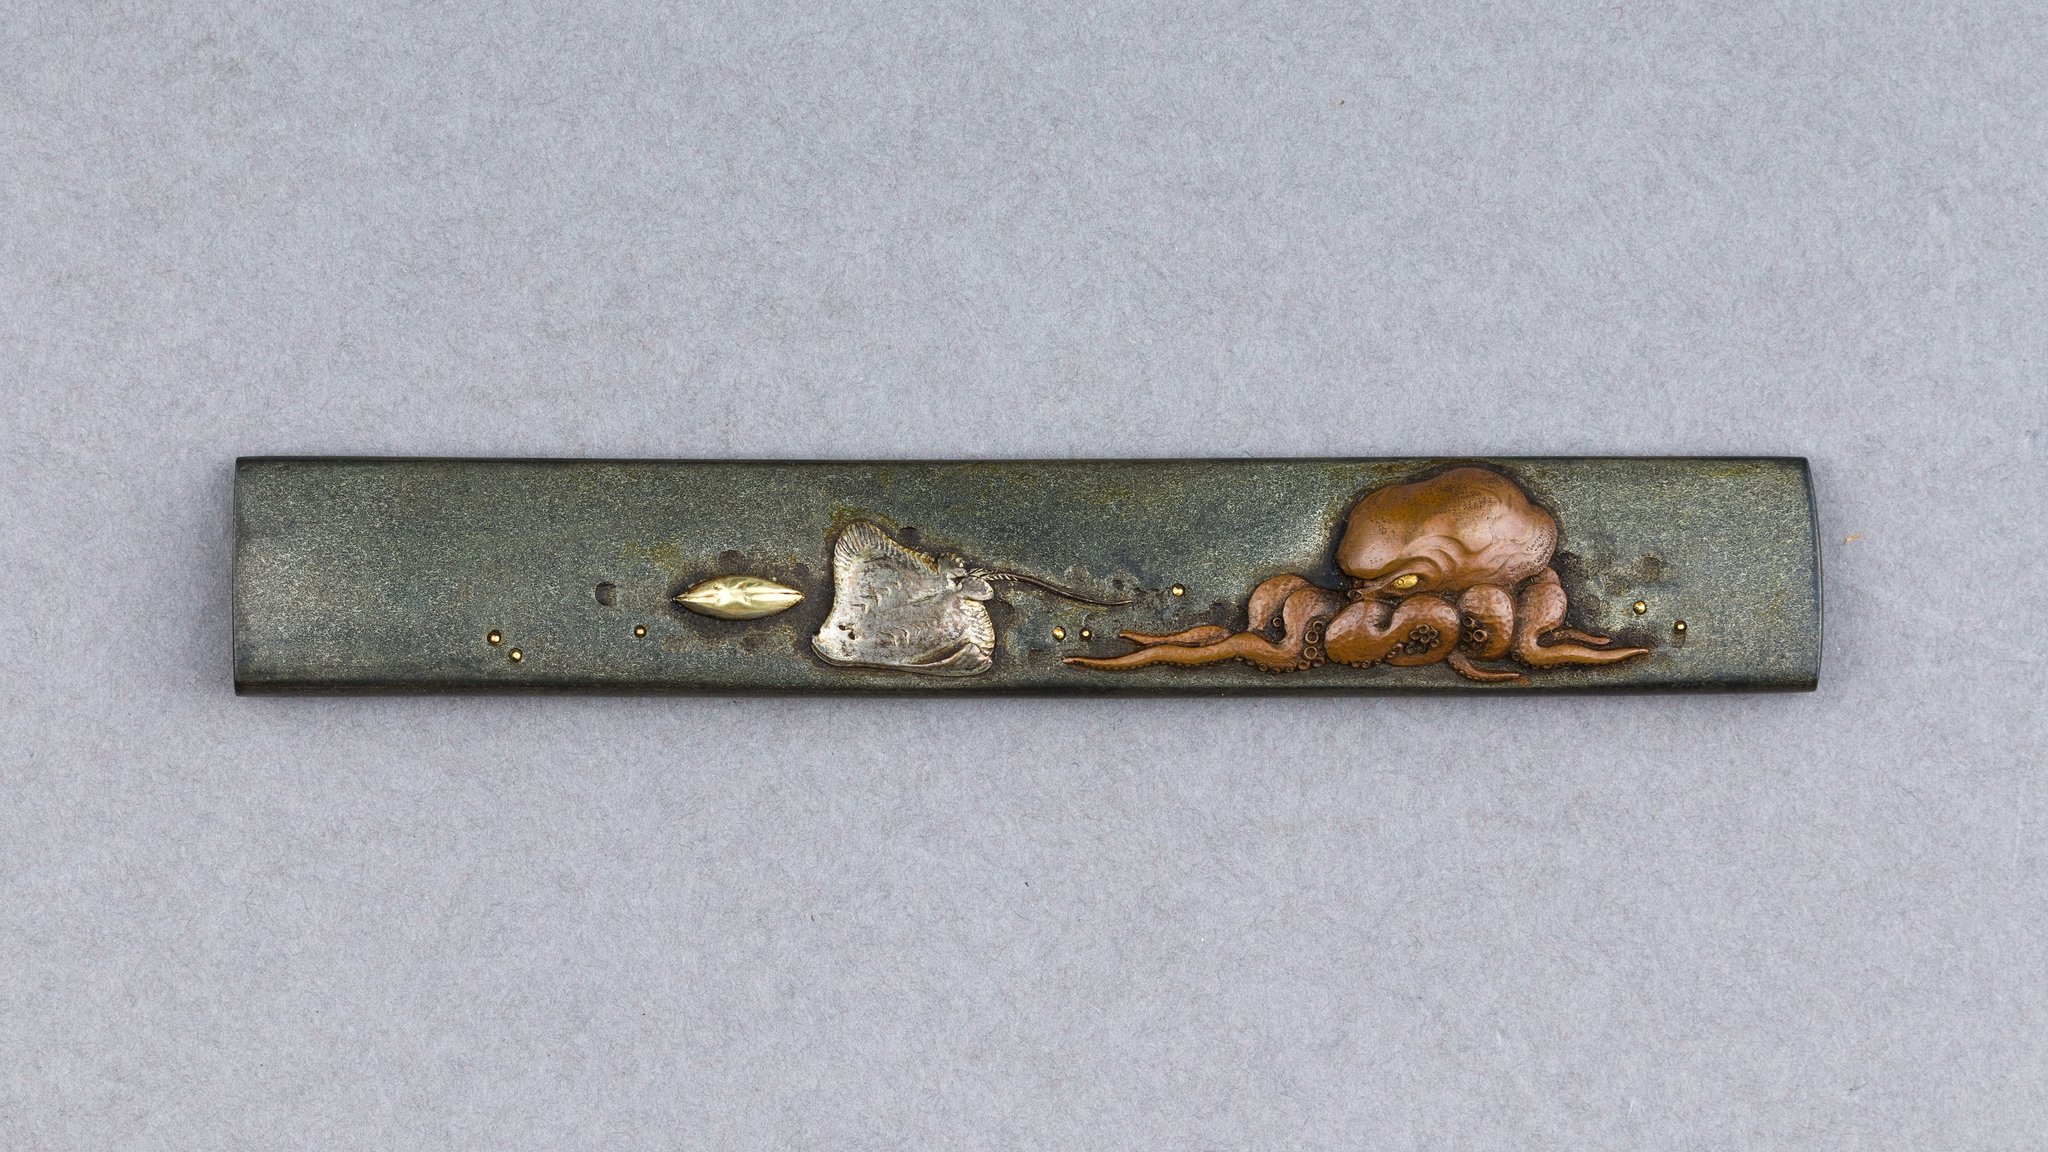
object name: knife handle kozuka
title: Knife Handle (Kozuka)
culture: japanese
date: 1615-1868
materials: copper, silver alloy, gold, silver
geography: japan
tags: octopus